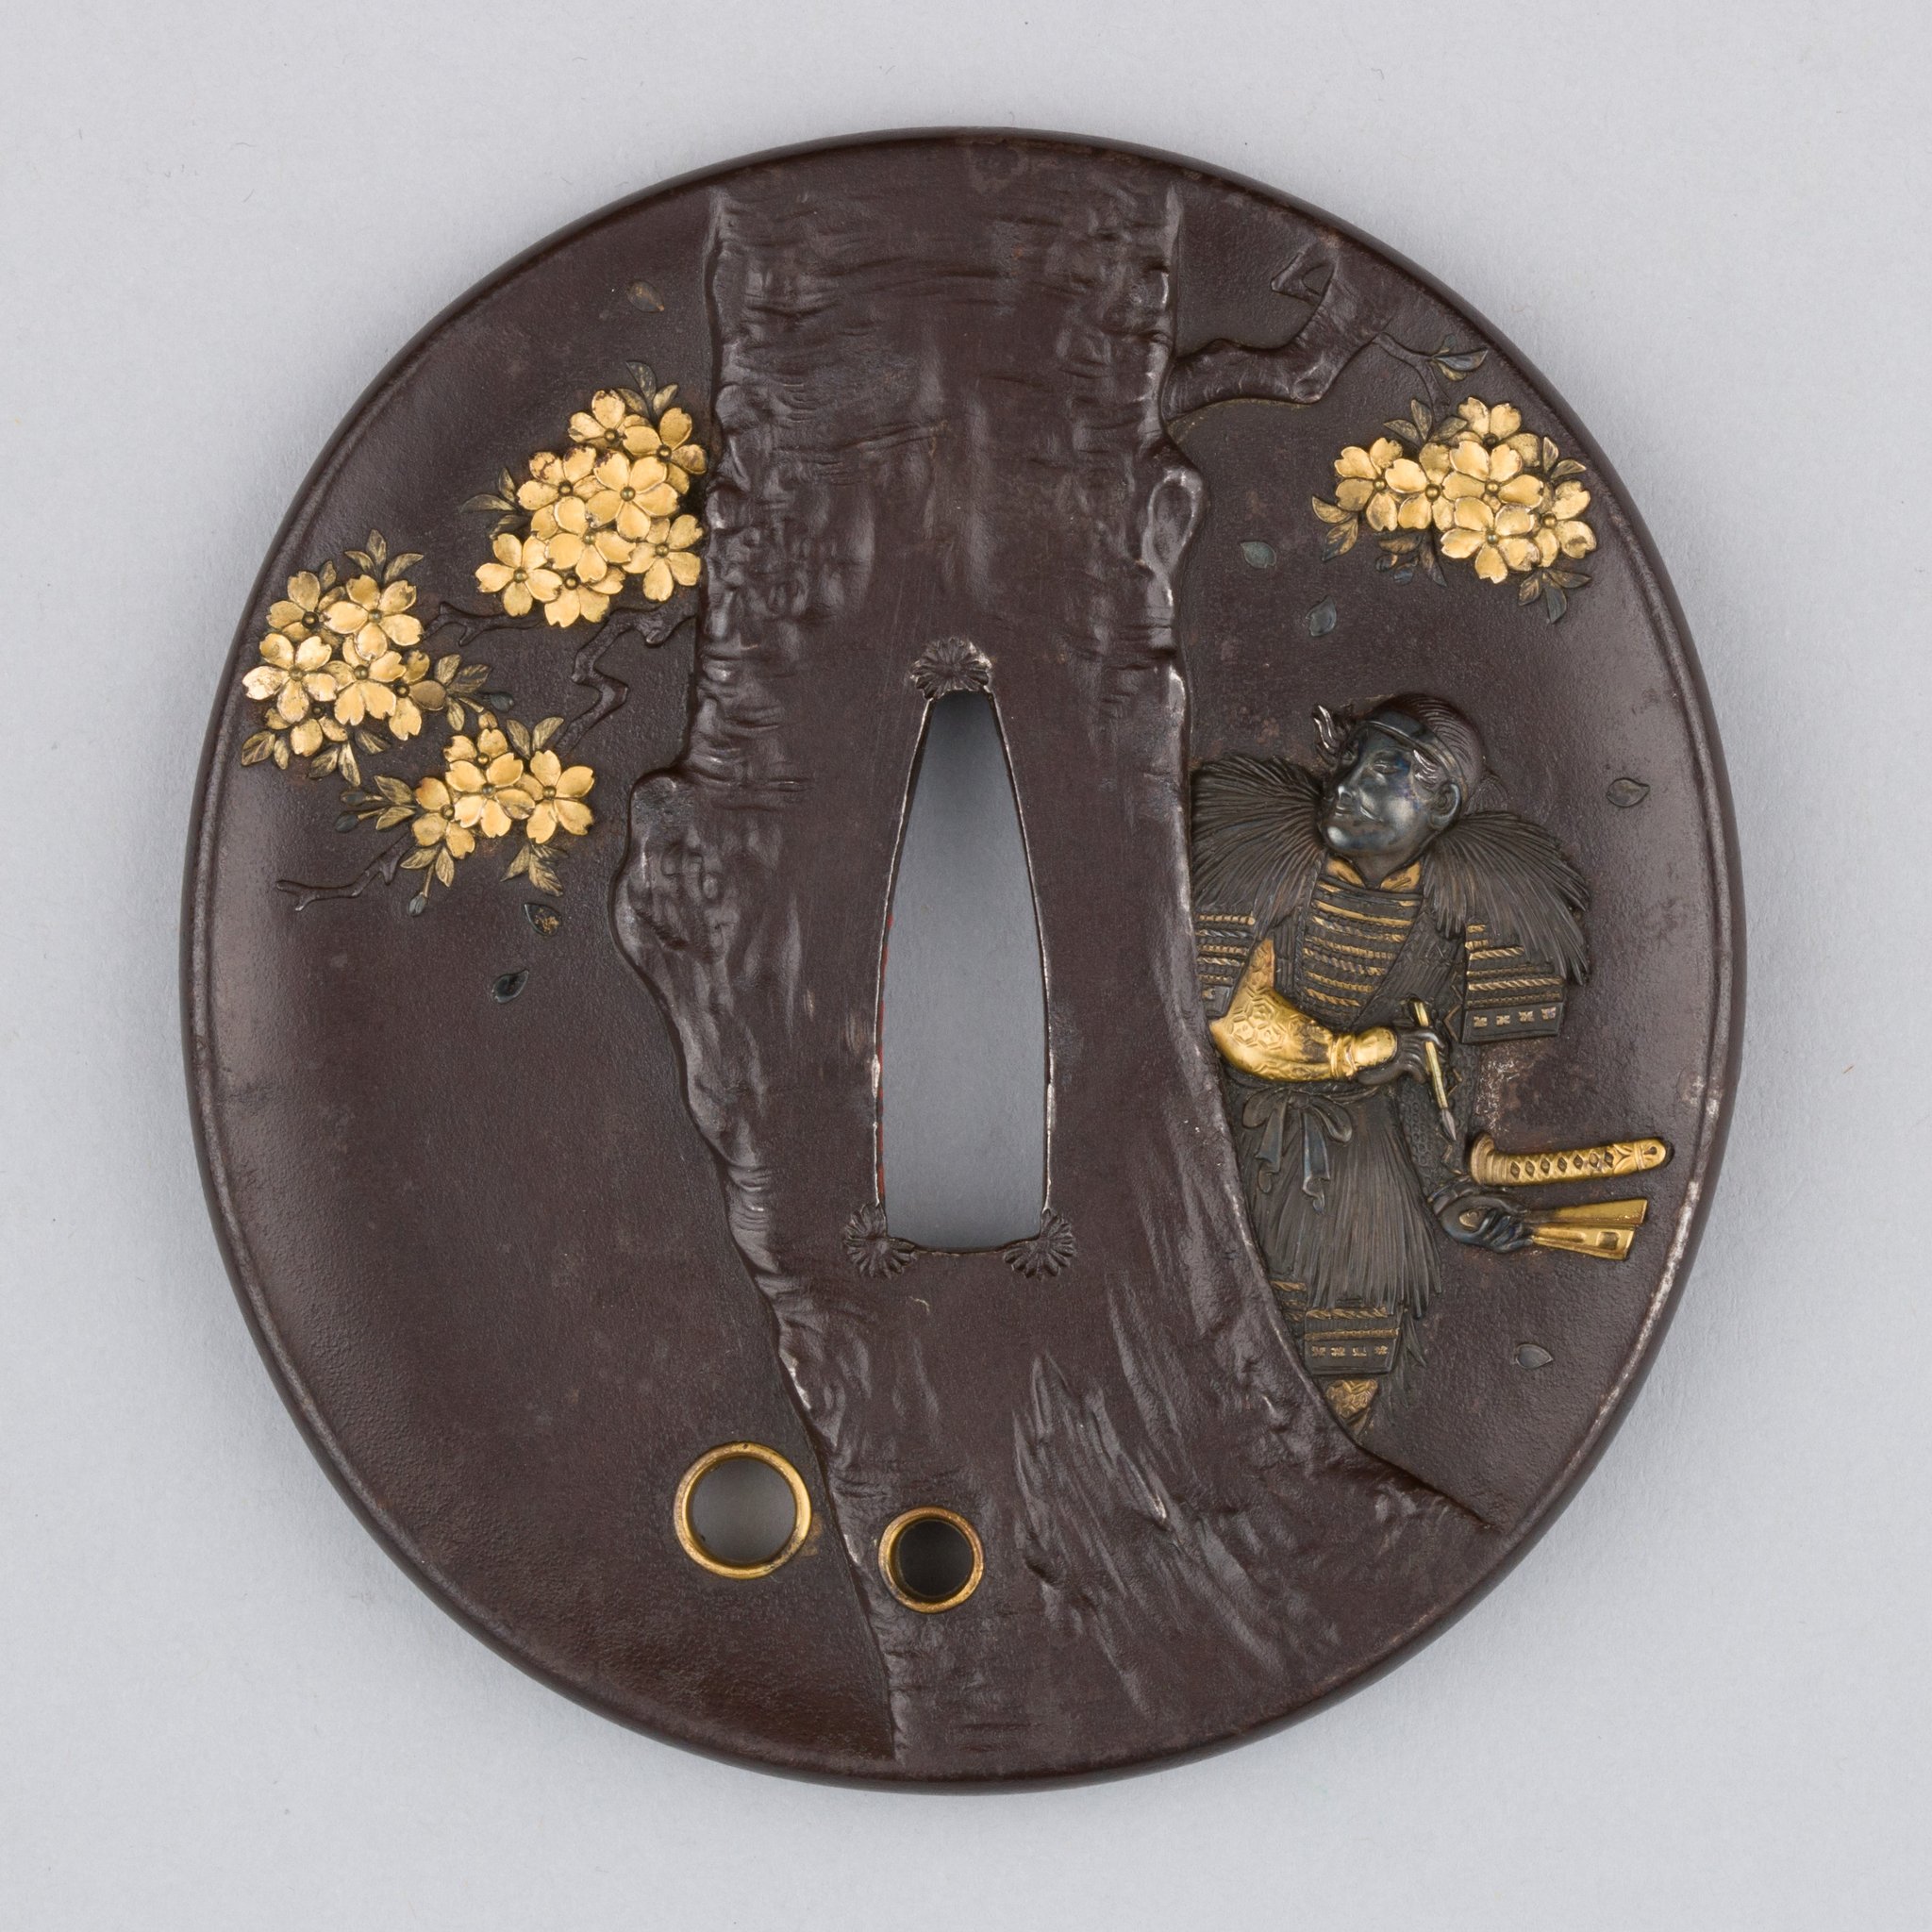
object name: sword guard tsuba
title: Sword Guard (Tsuba)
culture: japanese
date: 1701-1800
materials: bronze, copper, gold, iron, silver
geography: japan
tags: men,trees